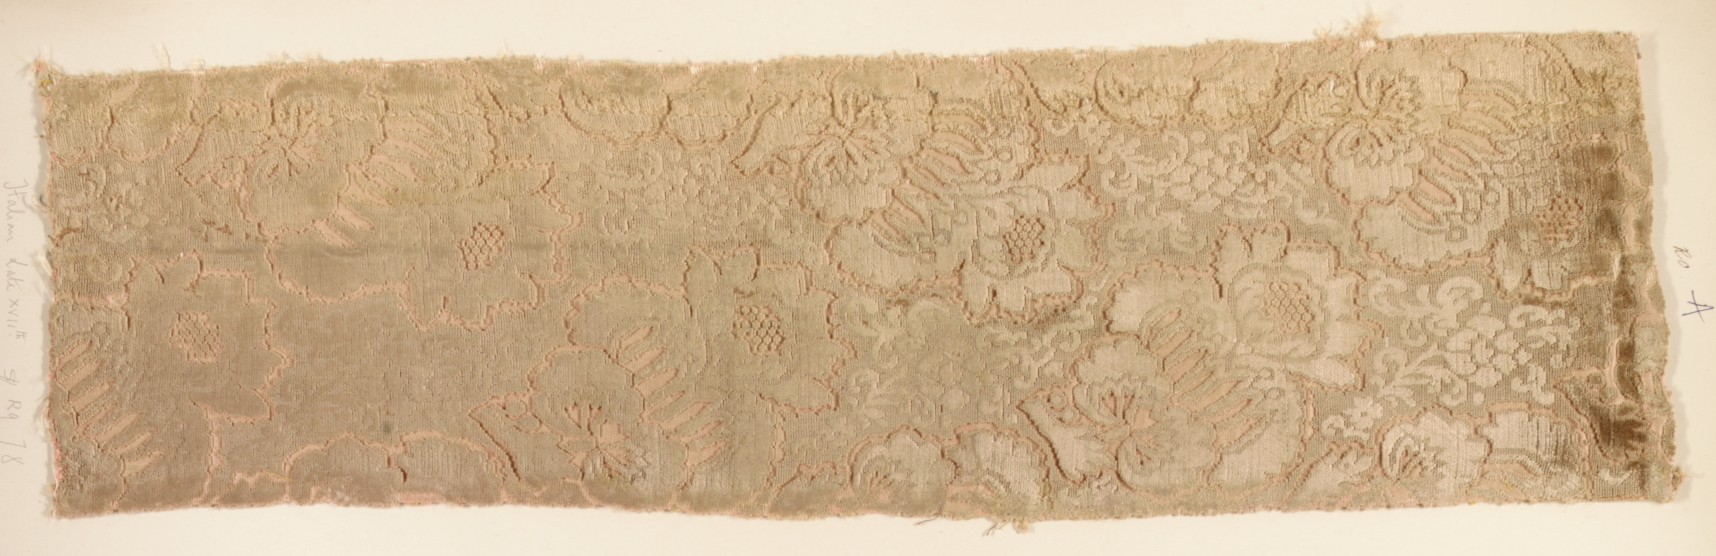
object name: fragment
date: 1501-1600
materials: silk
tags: flowers